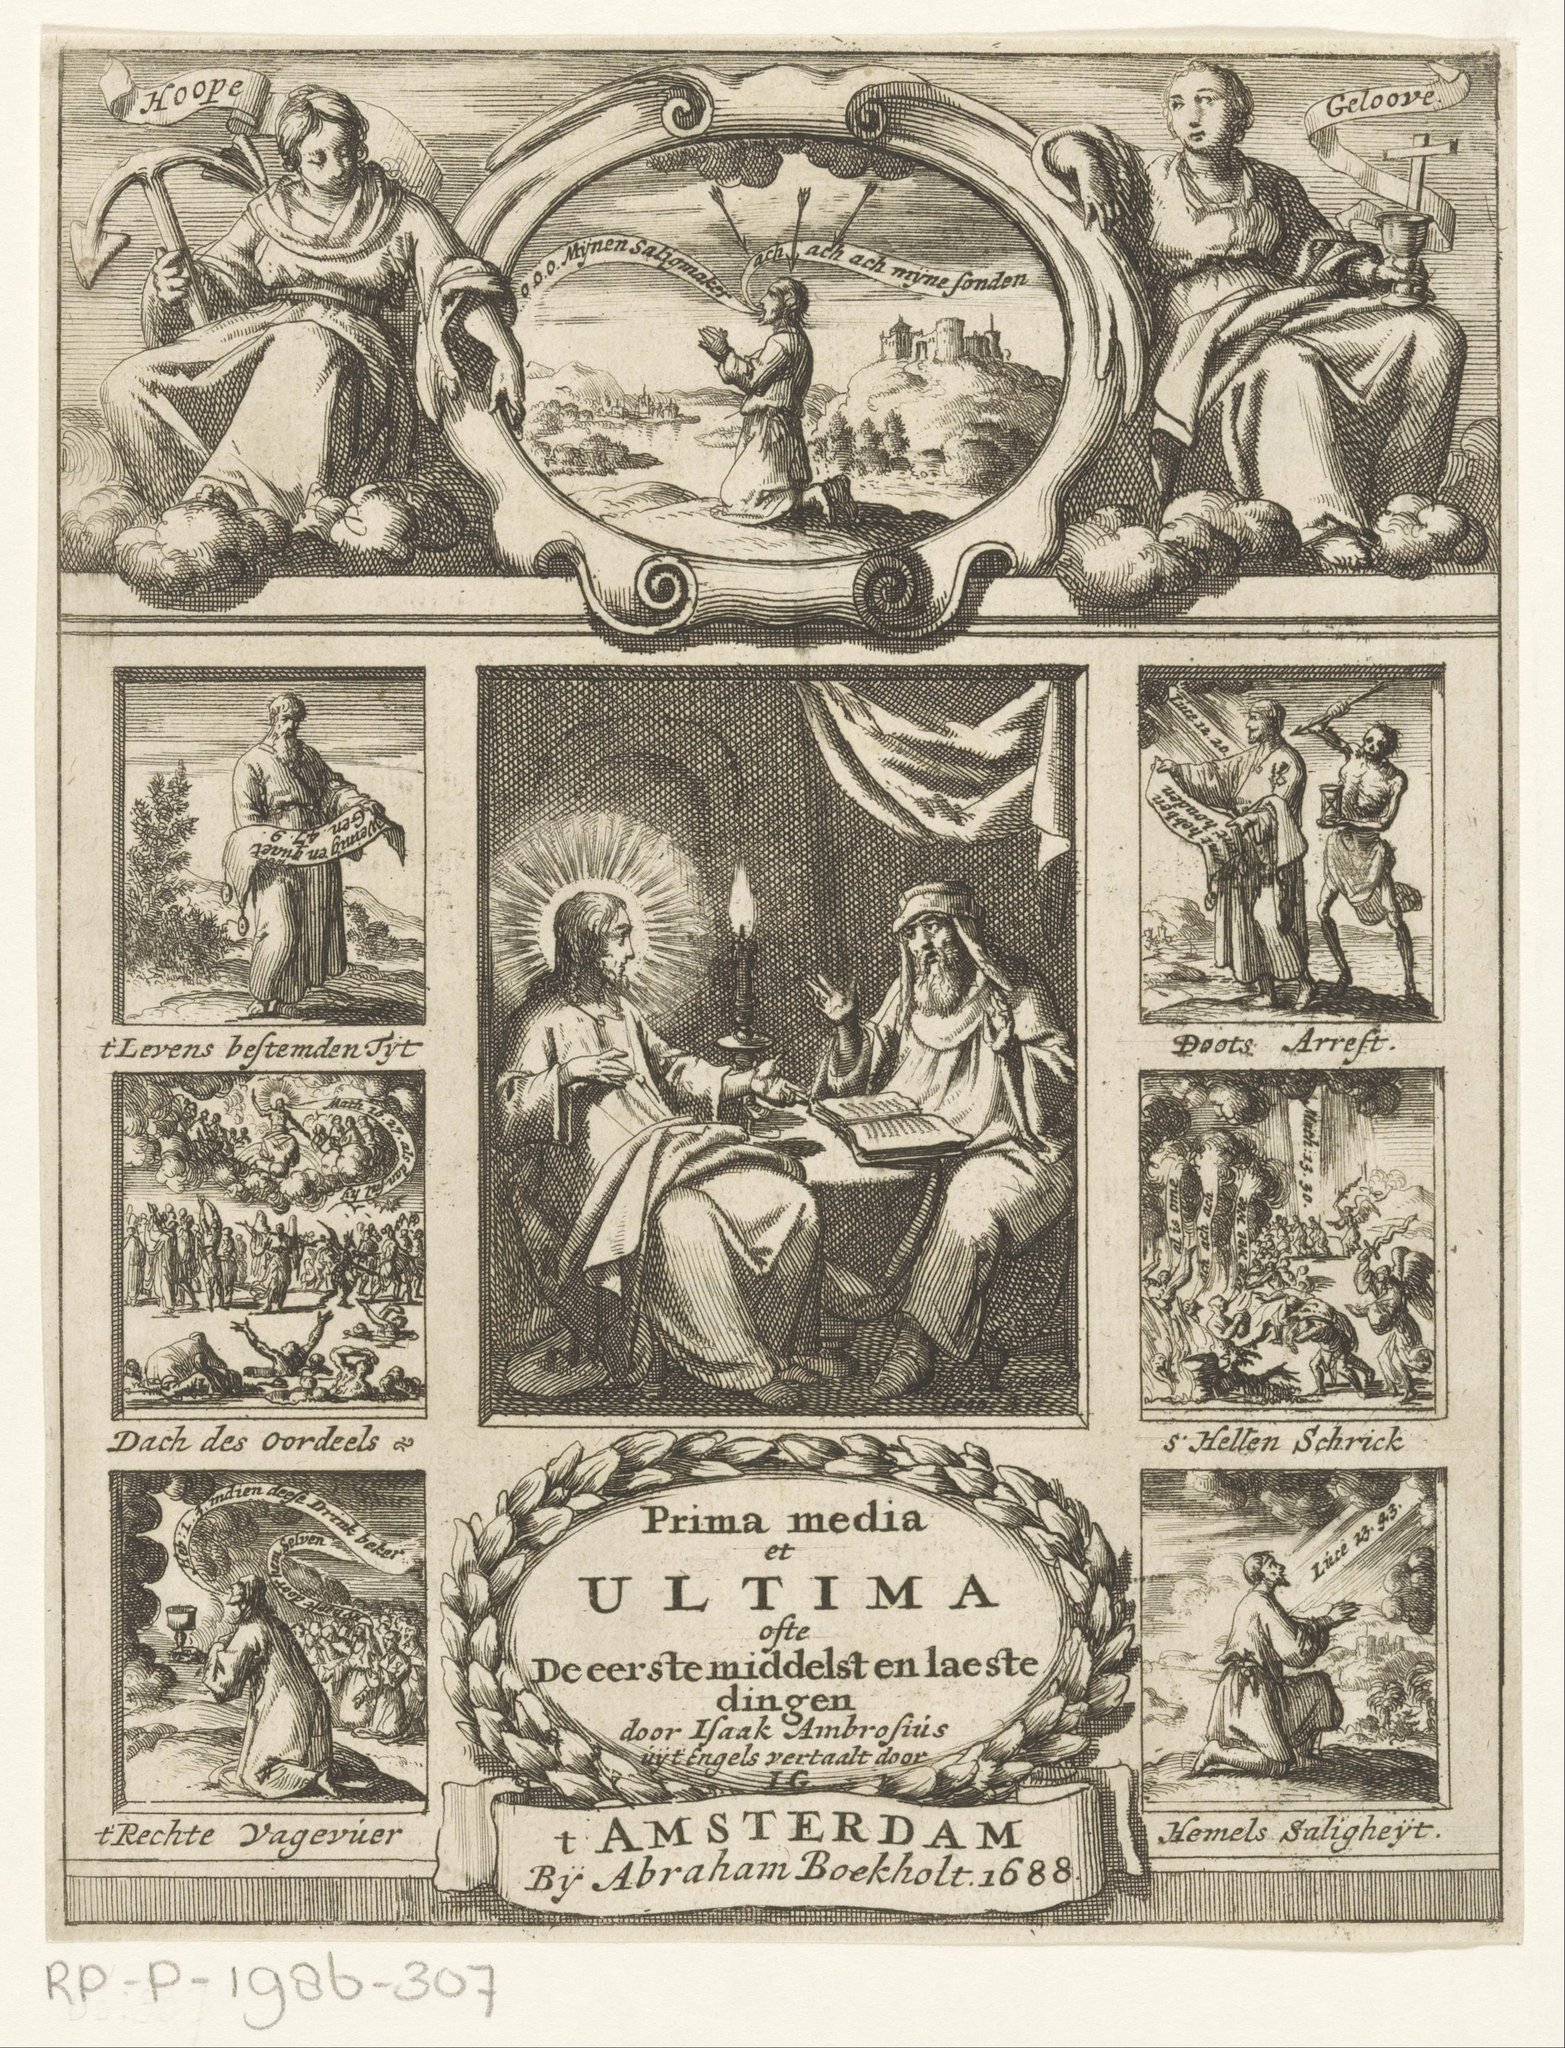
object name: print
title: Titelpagina voor: Isaac Ambrose, Prima, media, et ultima. Ofte De eerste, middelste, en laatste dingen, 1688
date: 1688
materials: paper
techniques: etching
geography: amsterdam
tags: fides (faith) as roman personification, hope, 'spes'; 'speranza divina e certa' (ripa) ~ one of the three theological virtues, christ talking with nicodemus at night (john 3:1-21), one person praying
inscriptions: collector's mark: Lugt 2228, collector's mark: Lugt 2760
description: Christus spreekt met Nicodemus bij kaarslicht. Links en rechts van deze centrale voorstelling zes scènes met verwijzingen naar bijbelverzen, voorzien van onderschriften. Bovenin flankeren de Hoop en het Geloof een cartouche met de beeltenis van een geknielde man in gebed.